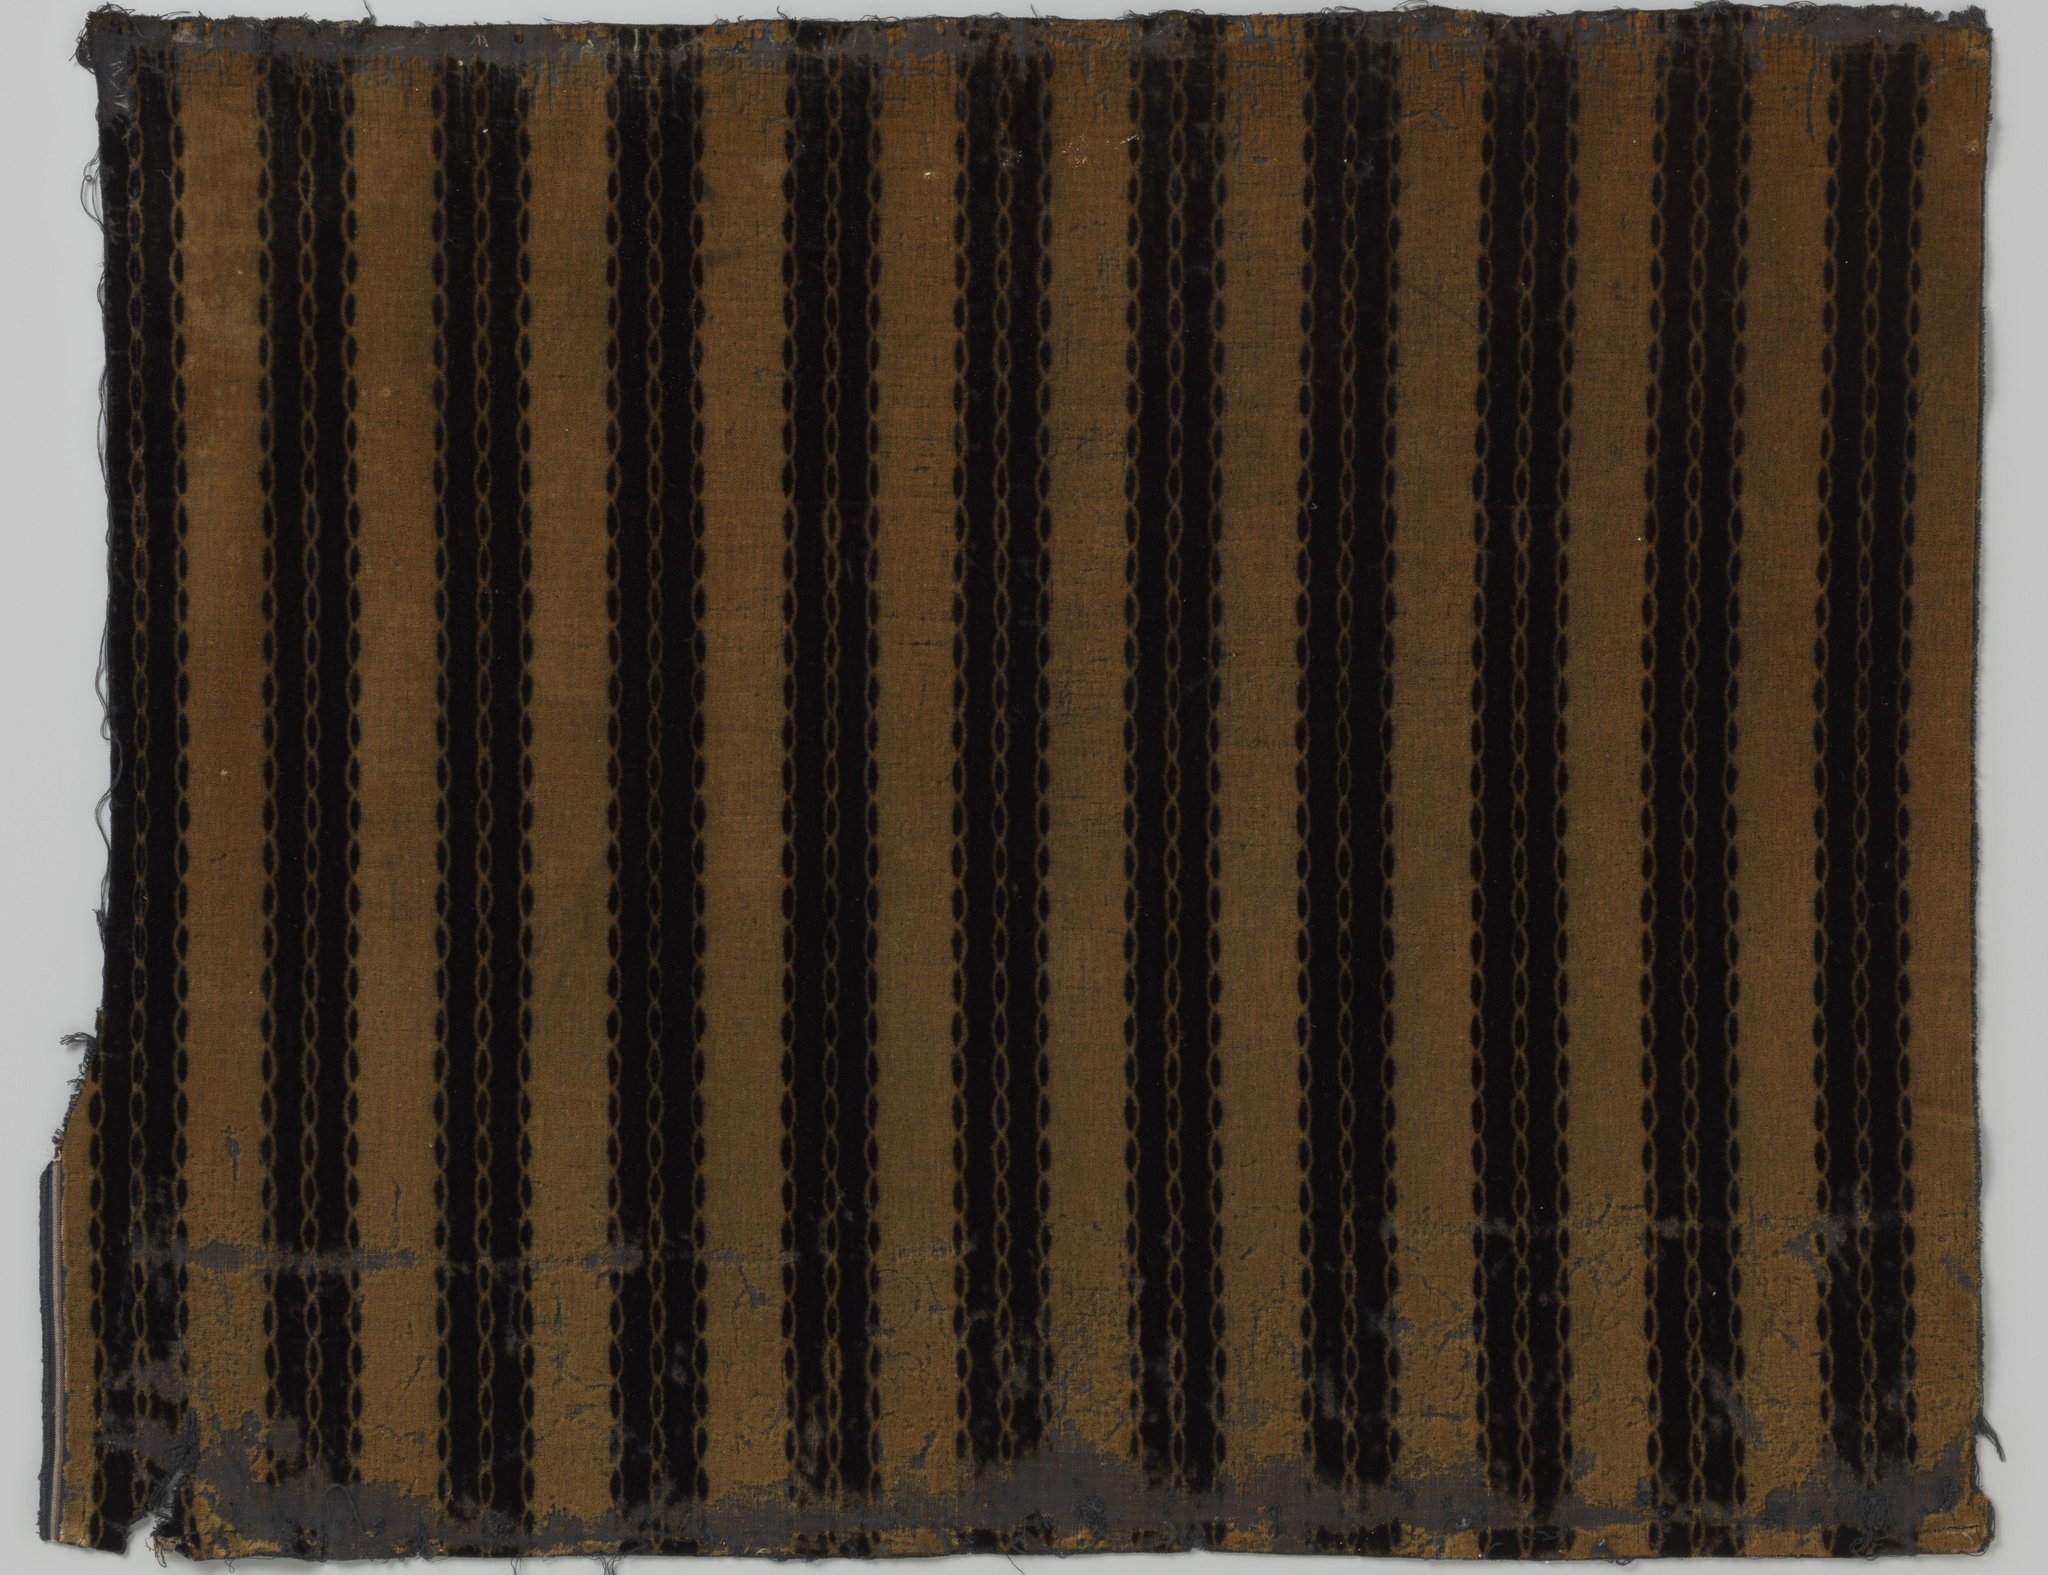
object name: bekledingsstof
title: Fragment bekledingsstof van bedrukte trijp met zwarte banden met kettingpatroon op een olijfgroene grond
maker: Anonymous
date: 1910-1920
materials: cotton, textile, hair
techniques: printing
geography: netherlands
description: Fragment bekledingsstof van bedrukte trijp. Op een olijfgroene grond lopen zwarte banden met kettingpatroon. Trijpgeweven met een v-binding.